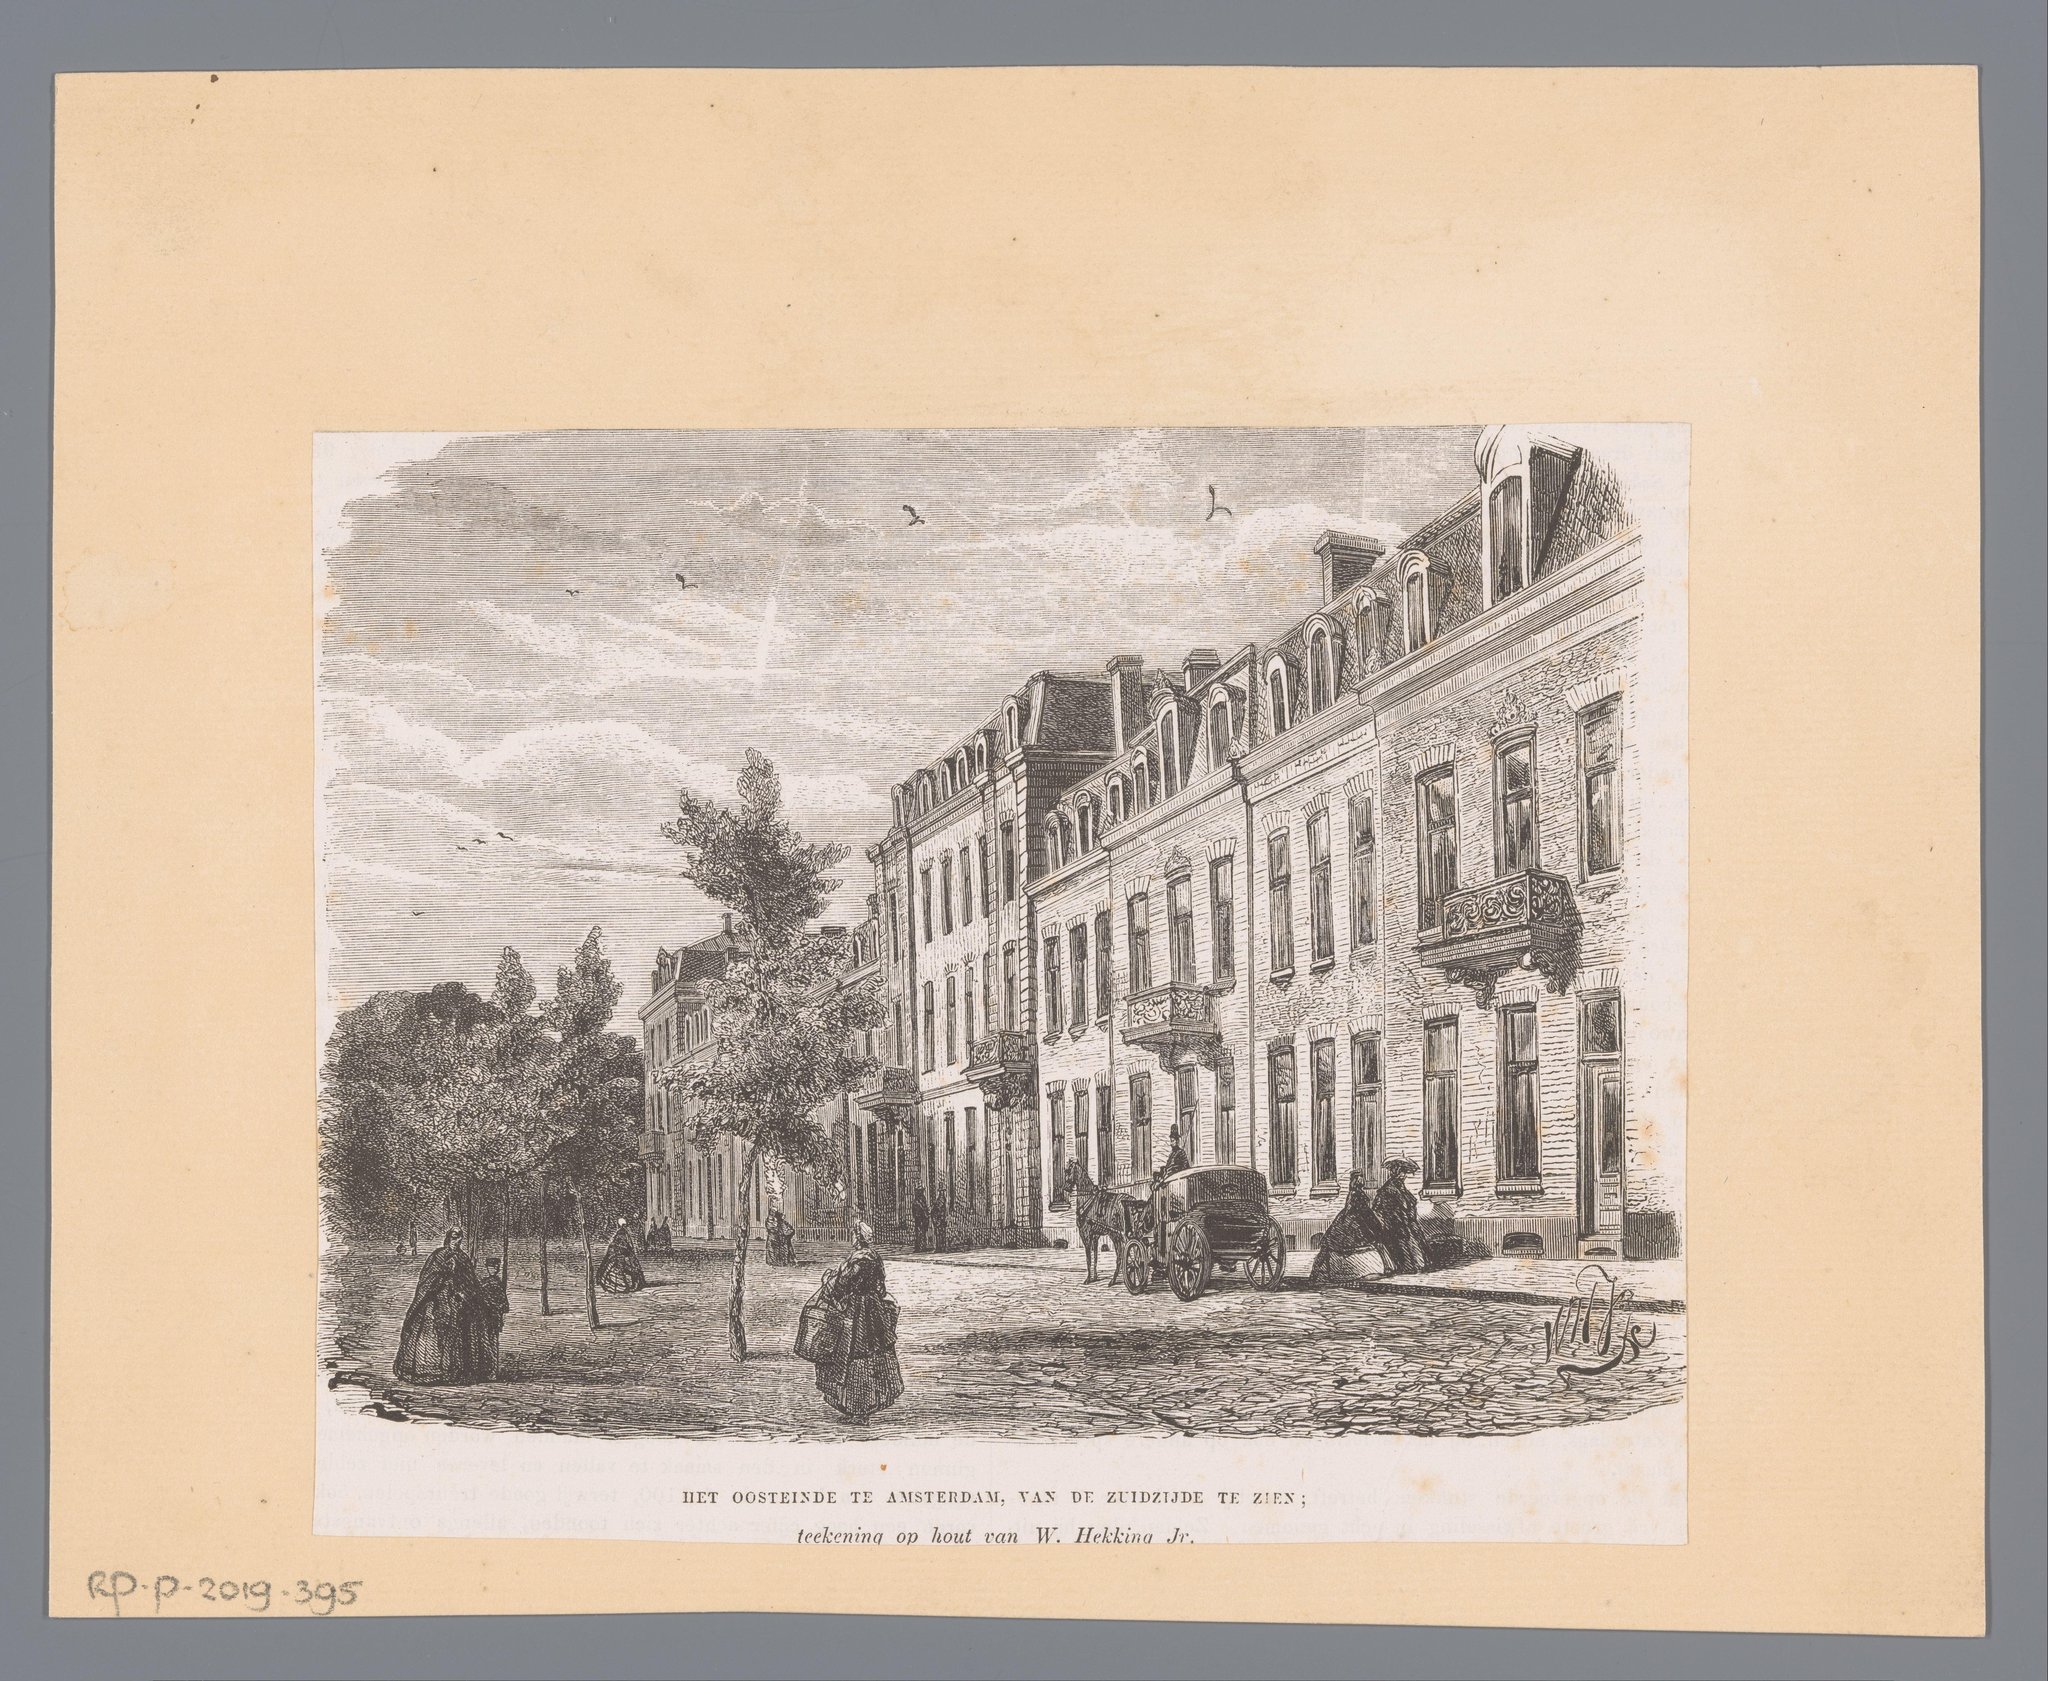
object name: book illustration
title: Het Oosteinde te Amsterdam van de zuidzijde te zien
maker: willem hekking jr.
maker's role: print maker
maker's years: 1825-1904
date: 1866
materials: paper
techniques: letterpress printing, engraving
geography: amsterdam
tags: urban housing, two-wheeled vehicle drawn by one animal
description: Prent uit: Het Nederlandsch magazijn, dl. 6 (1866), nr. 17, p. 129.